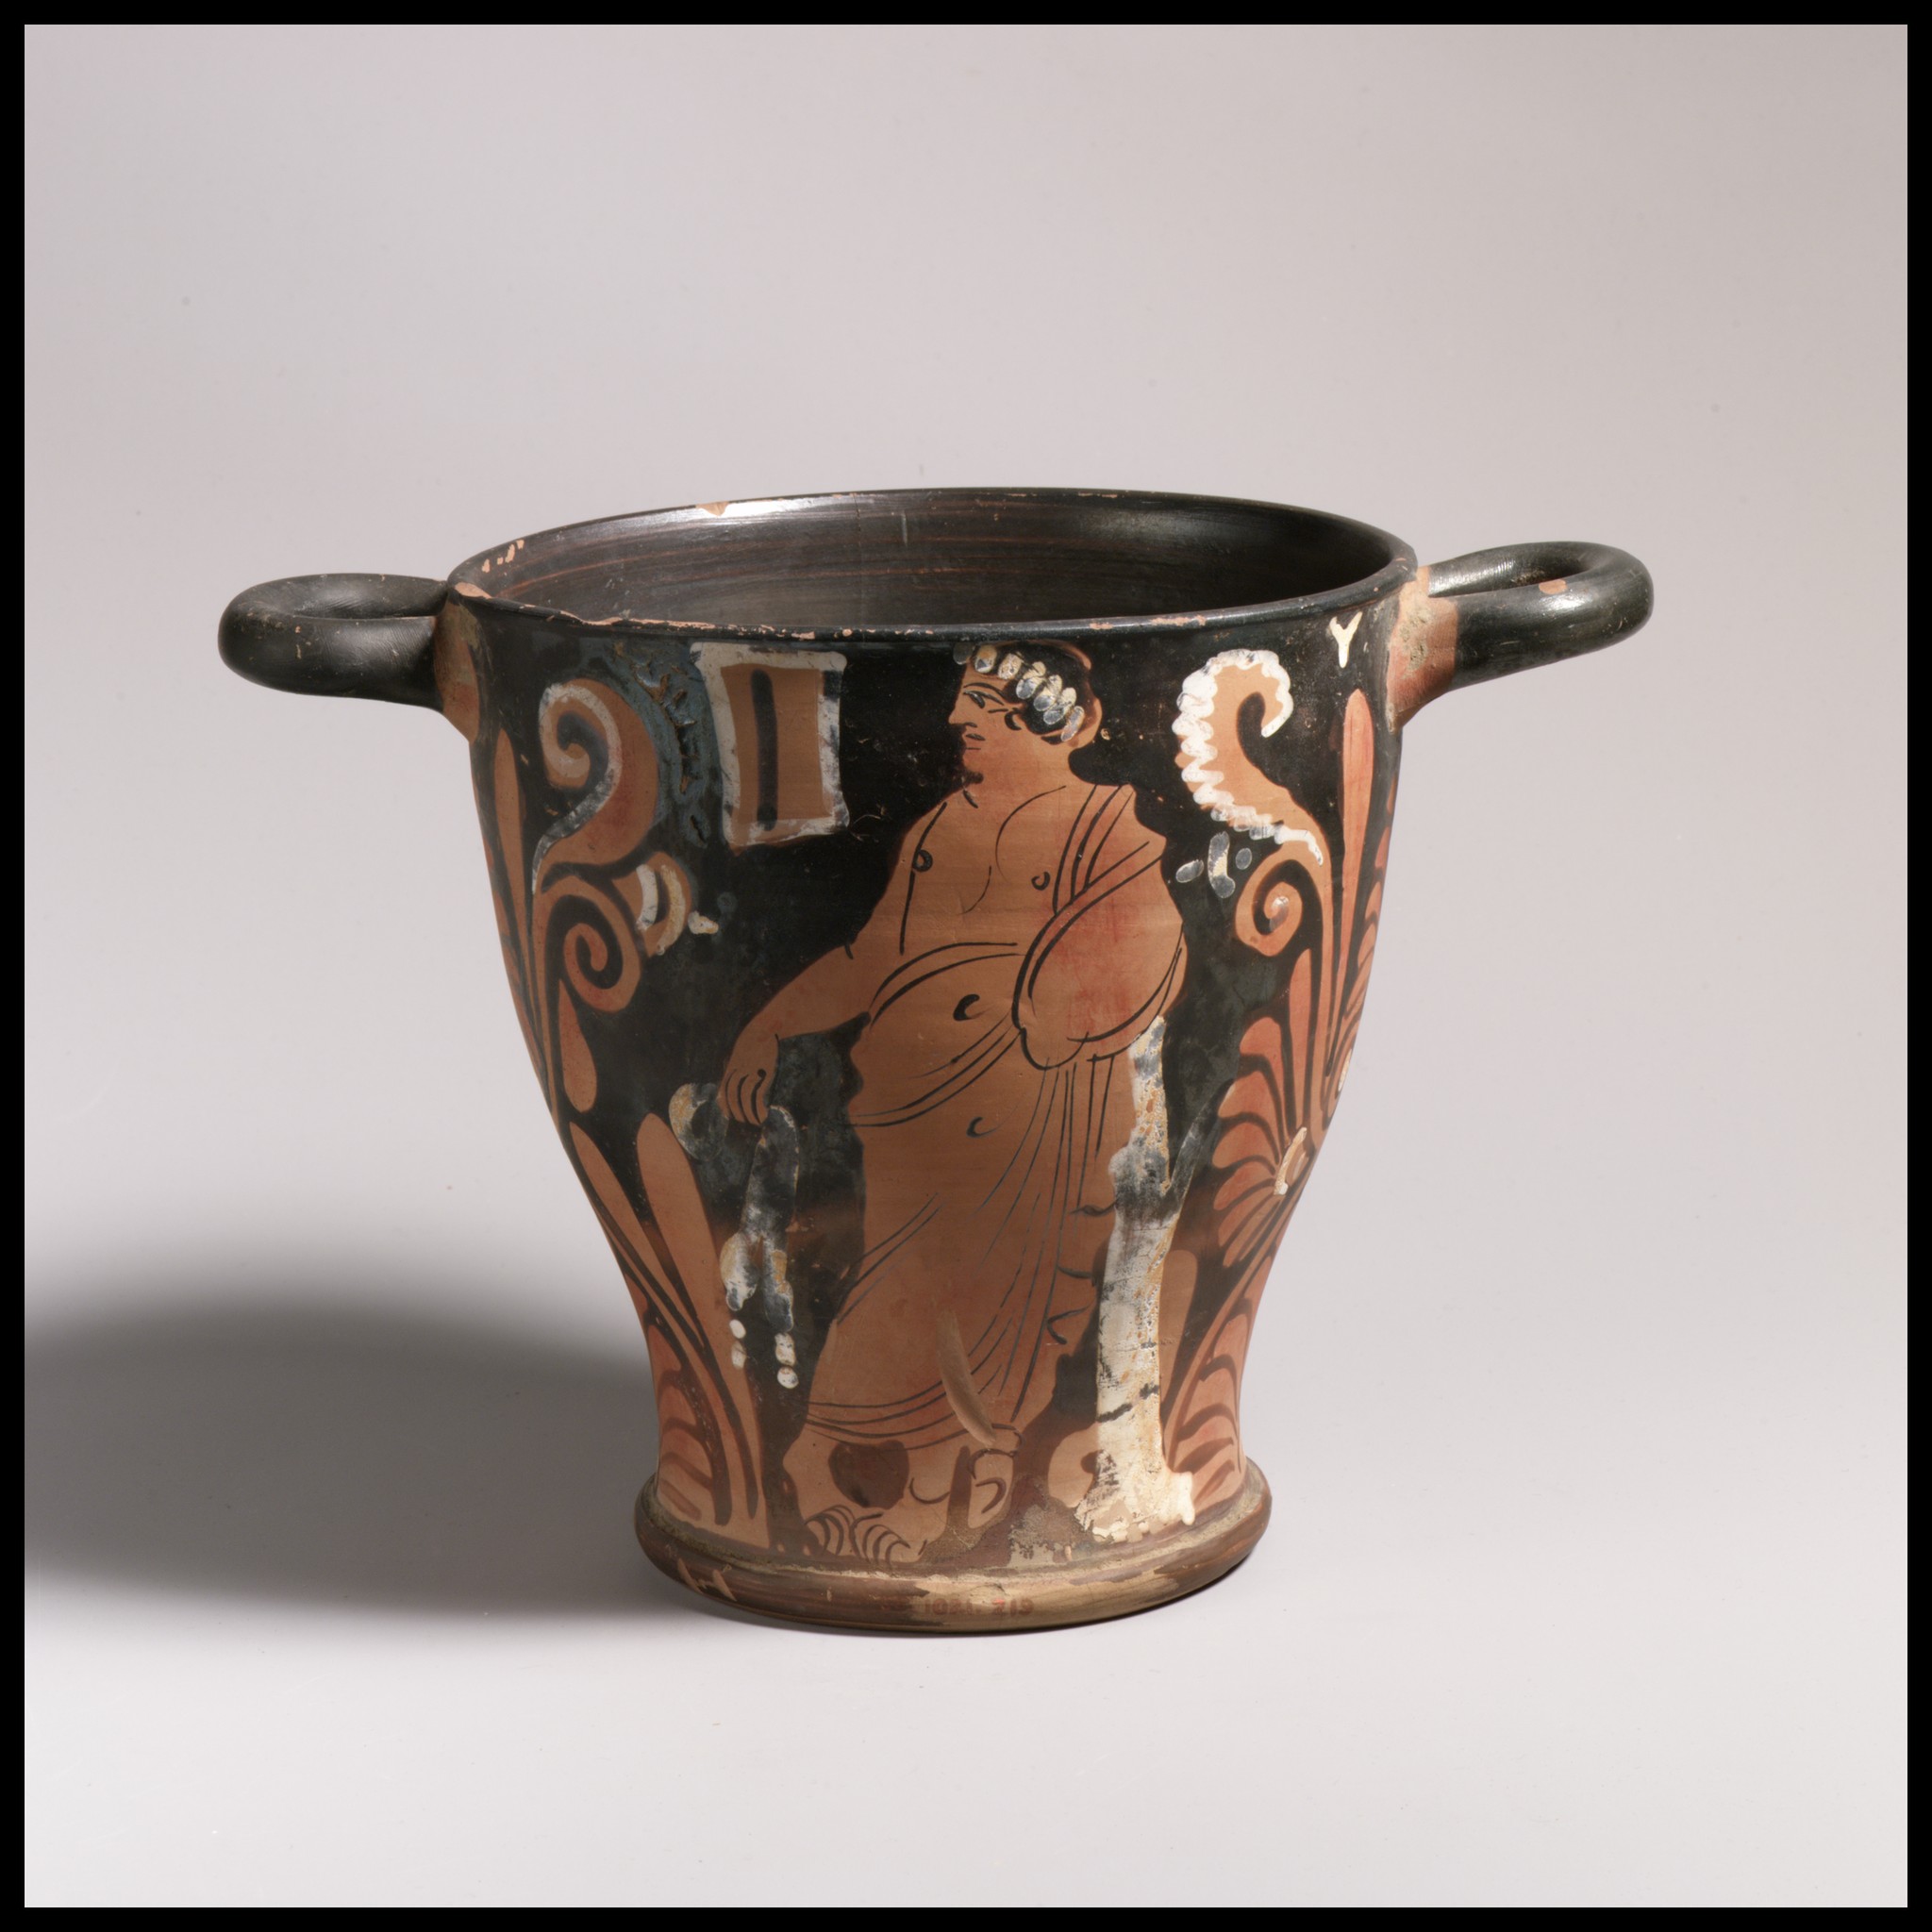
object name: skyphos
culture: greek or south italian or campanian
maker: manchester painter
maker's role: artist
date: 350-320 BCE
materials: terracotta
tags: men